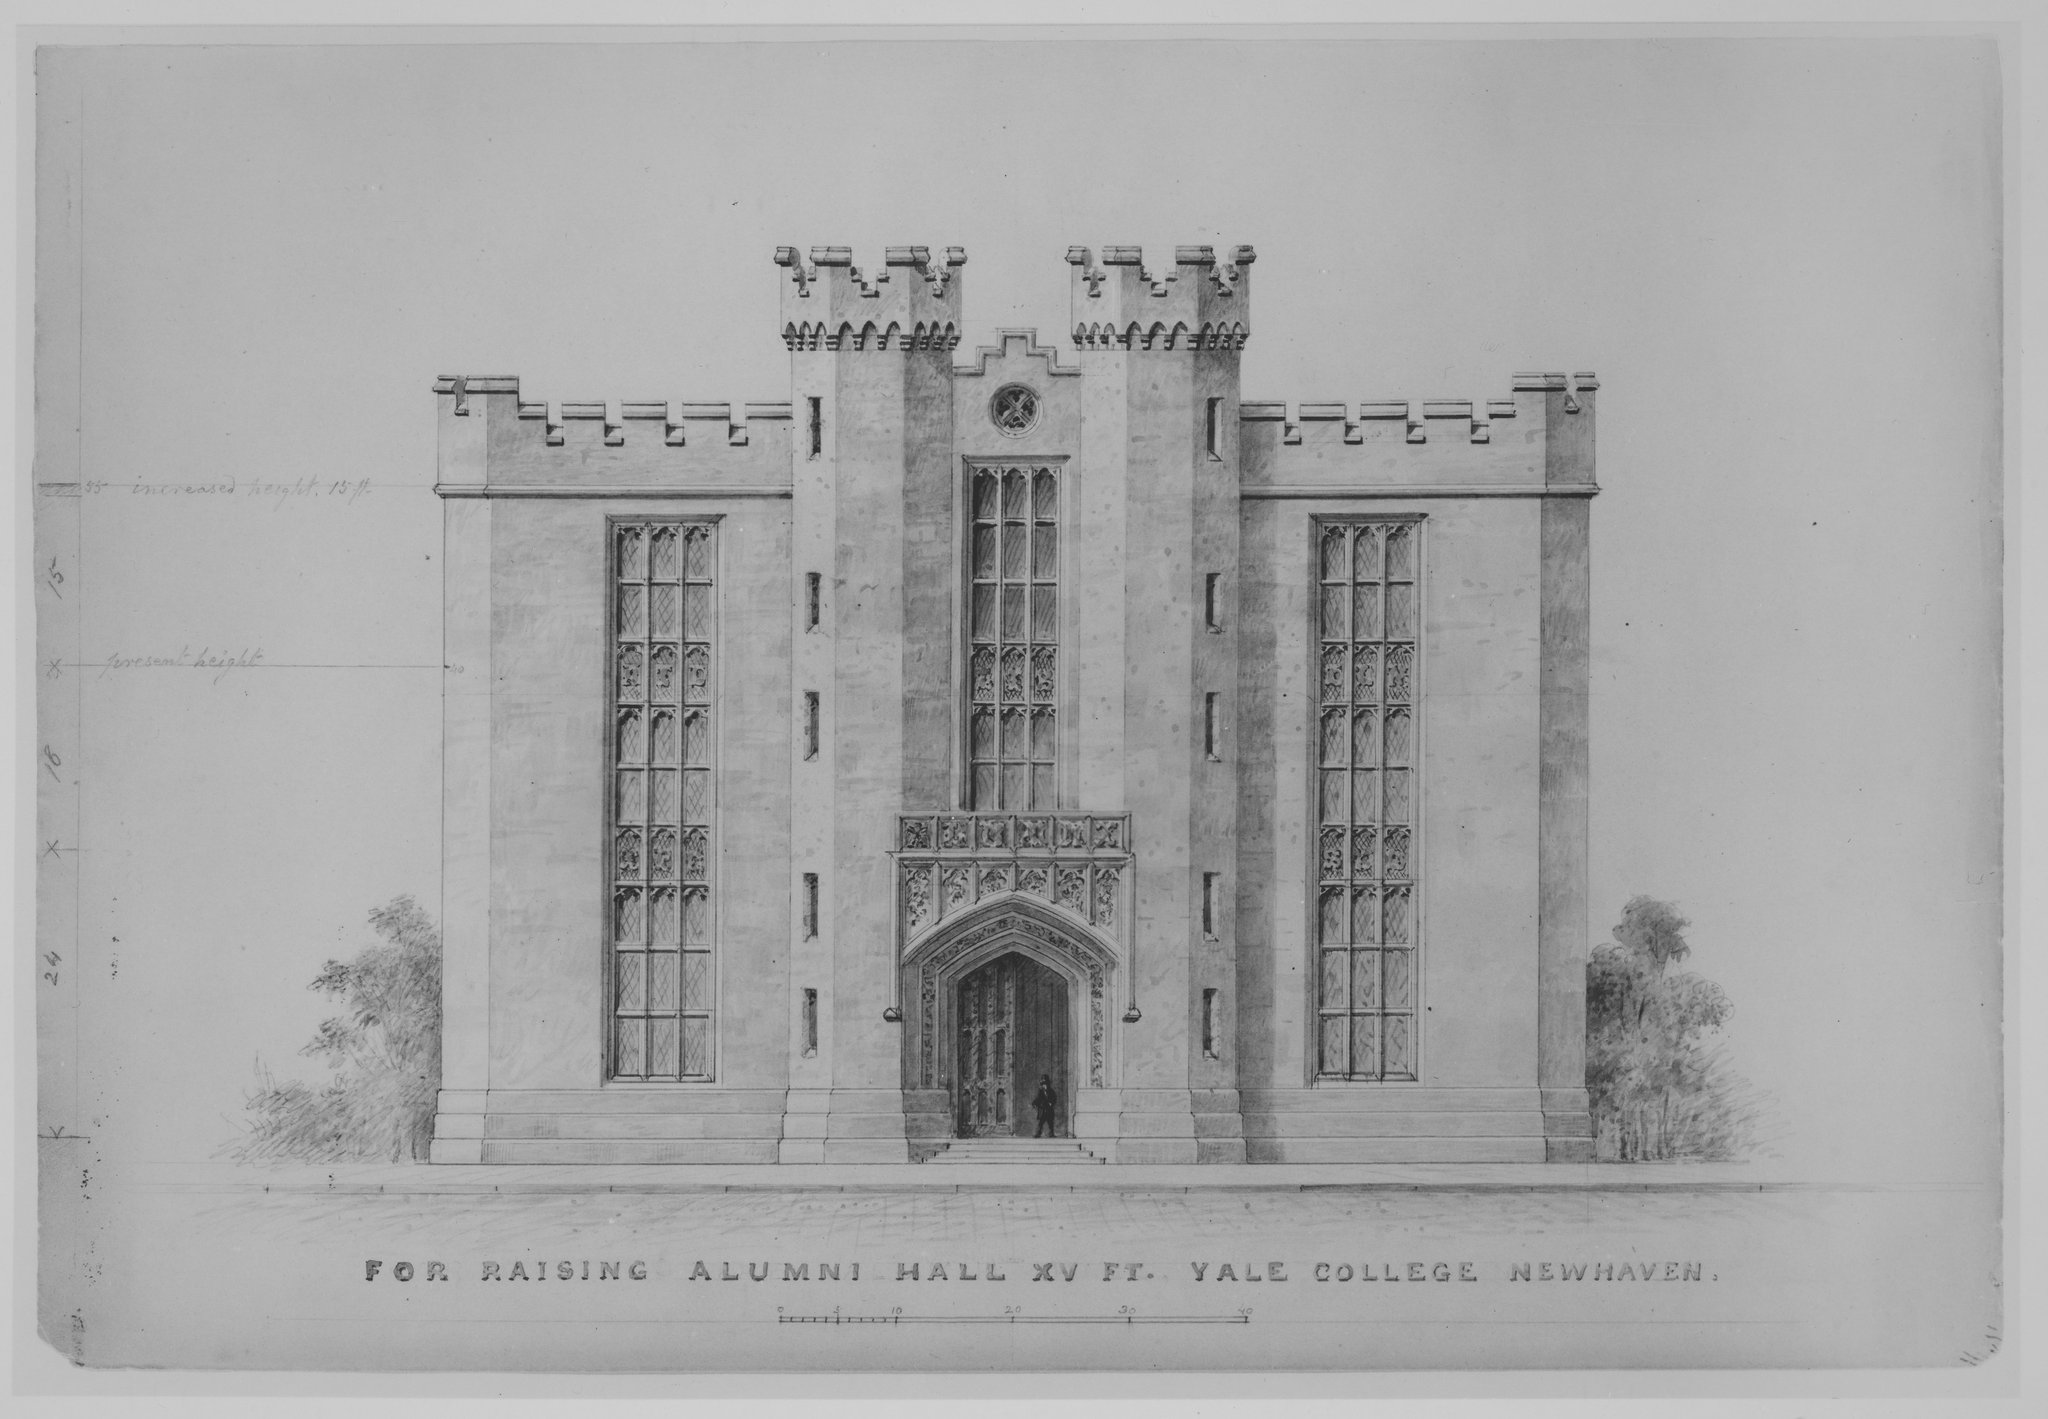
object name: drawing ornament architecture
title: Proposal for Raising by 15 feet, Alumni Hall, Yale College, New Haven (elevation of facade)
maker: alexander jackson davis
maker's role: artist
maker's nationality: american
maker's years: 1803-1892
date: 1881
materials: graphite, ink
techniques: pen, wash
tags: buildings